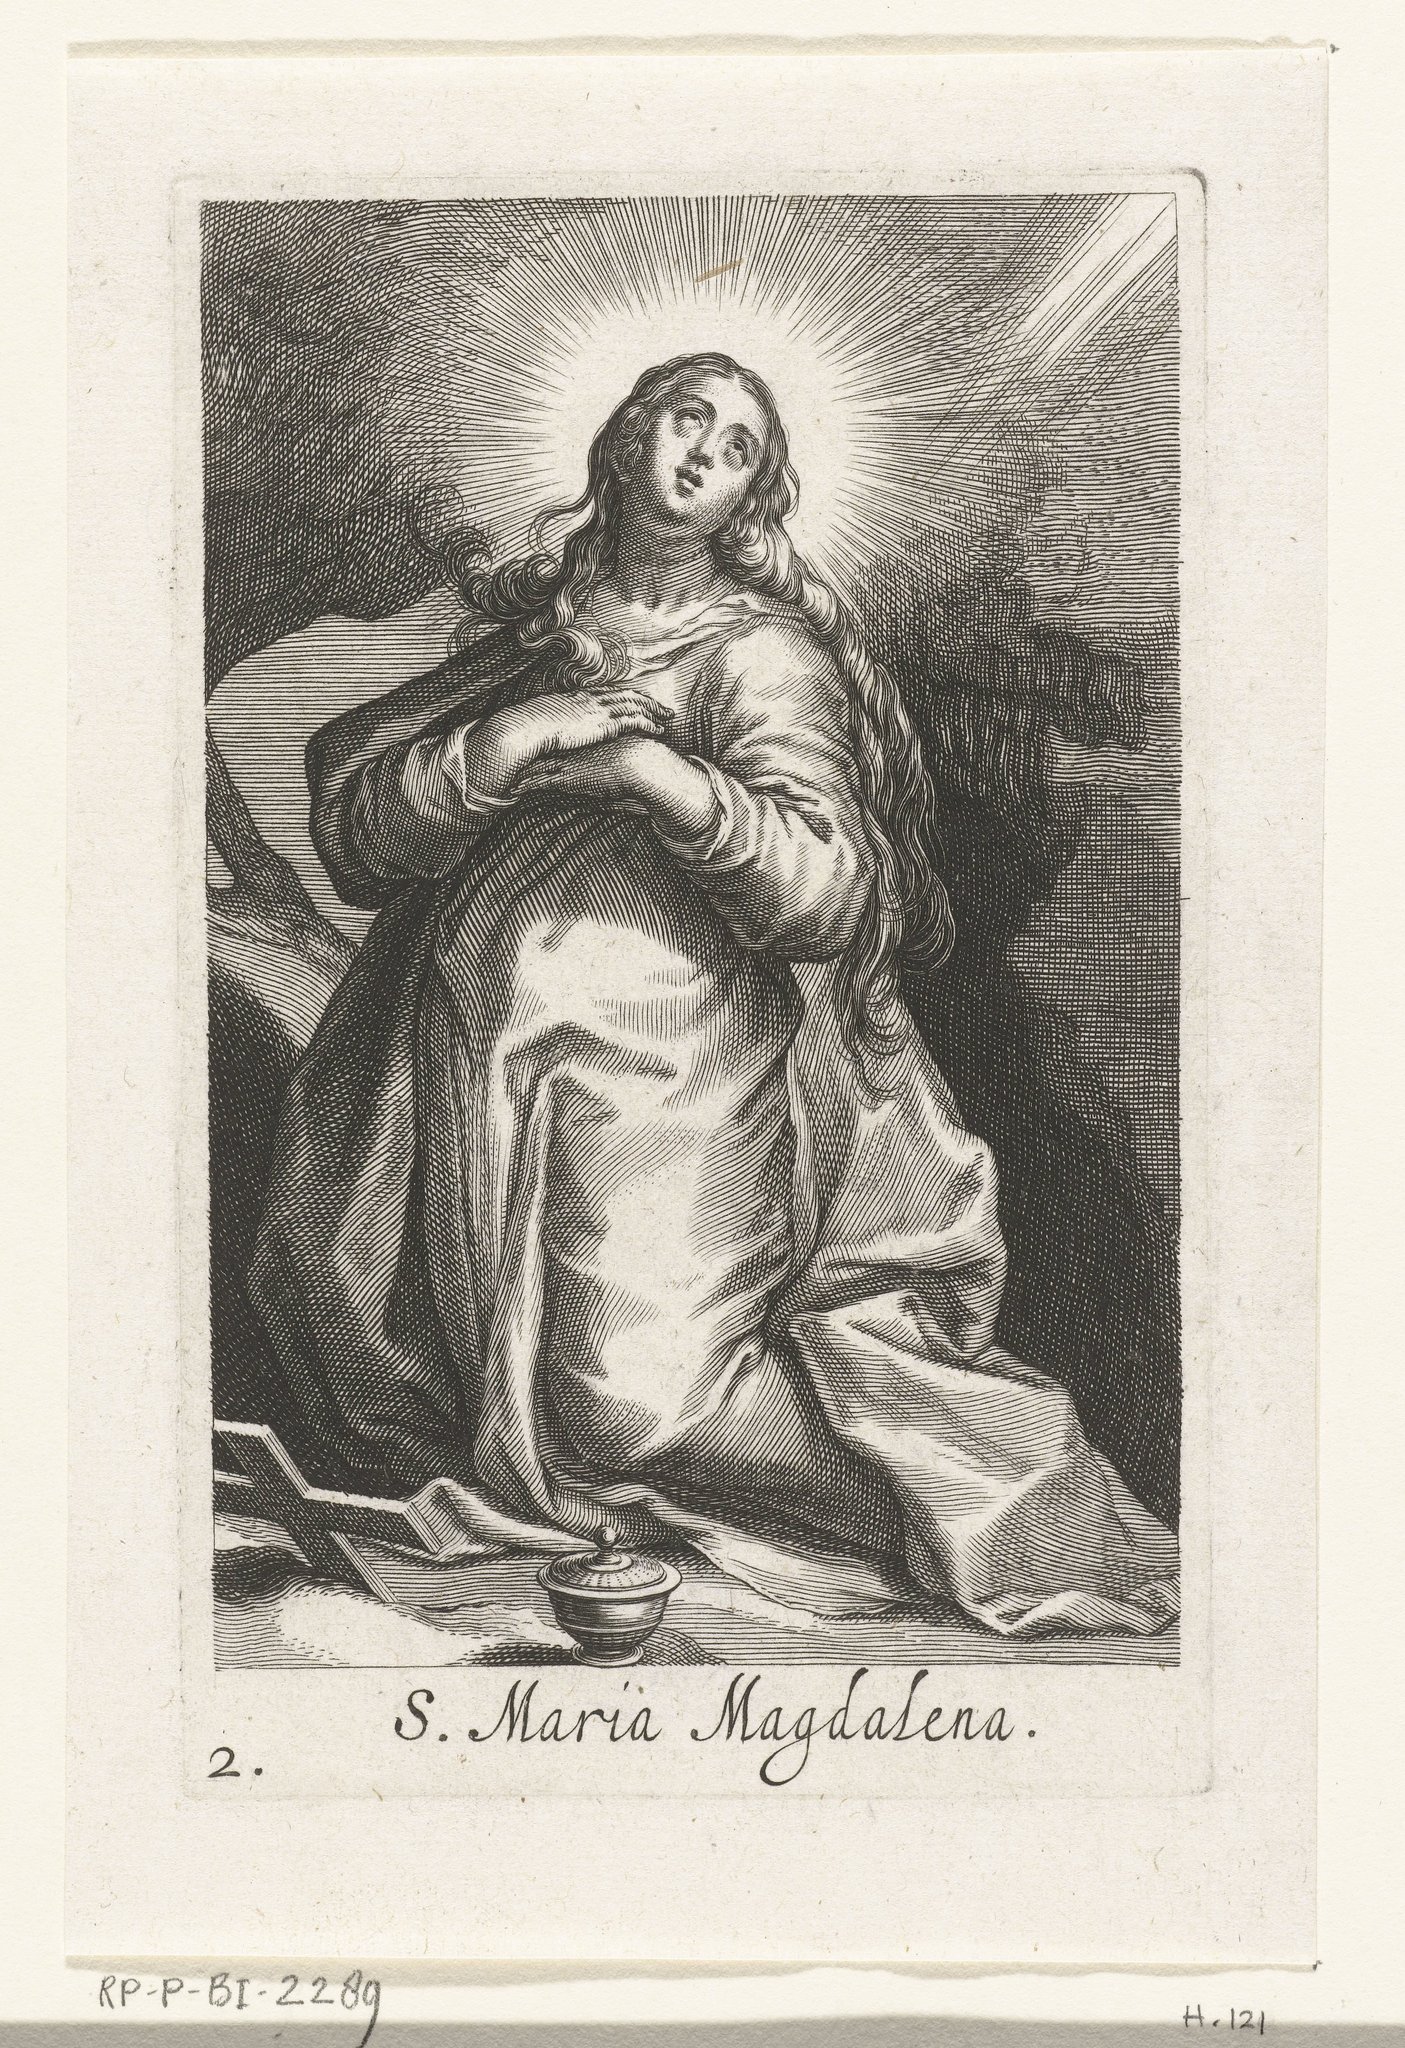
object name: book illustration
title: Kluizenaressen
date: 1590-1612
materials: paper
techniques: engraving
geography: amsterdam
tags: anchorite, hermit, the penitent harlot mary magdalene; possible attributes: book (or scroll), crown, crown of thorns, crucifix, jar of ointment, mirror, musical instrument, palm-branch, rosary, scourge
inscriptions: collector's mark: Lugt 2228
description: Prent uit: Sacra Eremus Ascetriarum, uitgever Boëtius Adamsz. Bolswert, 1612 of Hendrik Aertssen, Antwerpen 1619. Prent uit de serie van vijfentwintig kluizenaressen in deze uitgaven. In 1612 verscheen een ongebonden editie maar op basis van de gewijzigde opschriften en samenstelling van de serie kluizenaars wordt aangenomen dat de prenten van de uitgave 1619 ook in 1612 of iets daarvoor gedrukt werden. De serie kluizenaressen bleef vrijwel ongewijzigd in de ongebonden uitgave van 1612, dit compliceert de datering van de losse bladen in de collectie van het RMA, zie Roethlisberger 1993, p. 171-175.